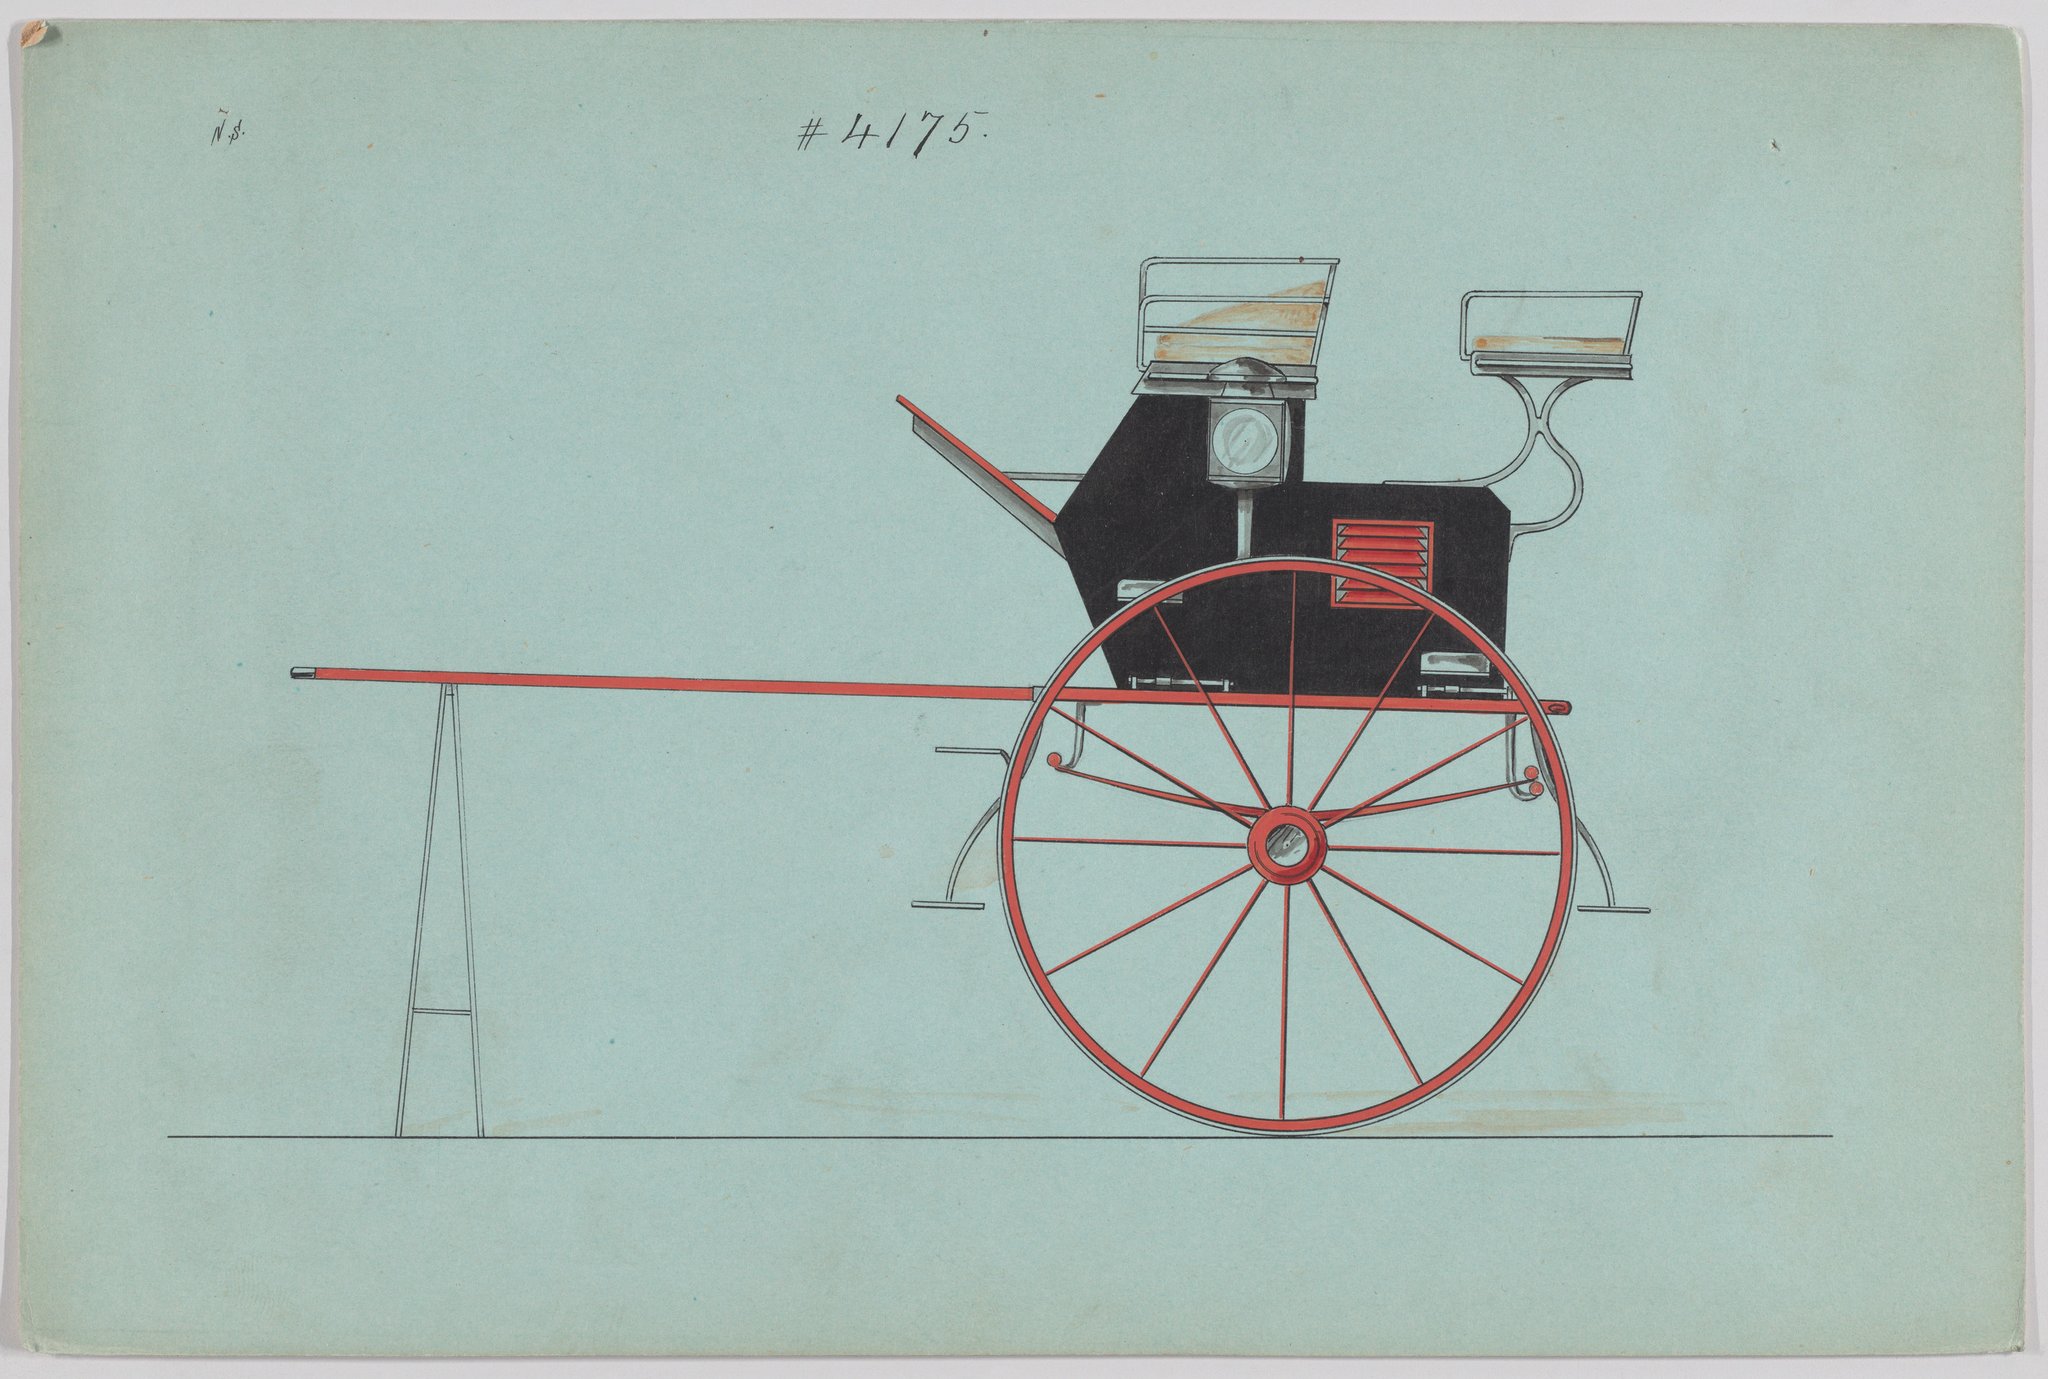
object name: drawing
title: Design for Dog Cart or 2 Wheeler, no. 4175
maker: brewster & co.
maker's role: manufacturer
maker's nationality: american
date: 1892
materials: gouache, ink, watercolor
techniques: pen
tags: carriages